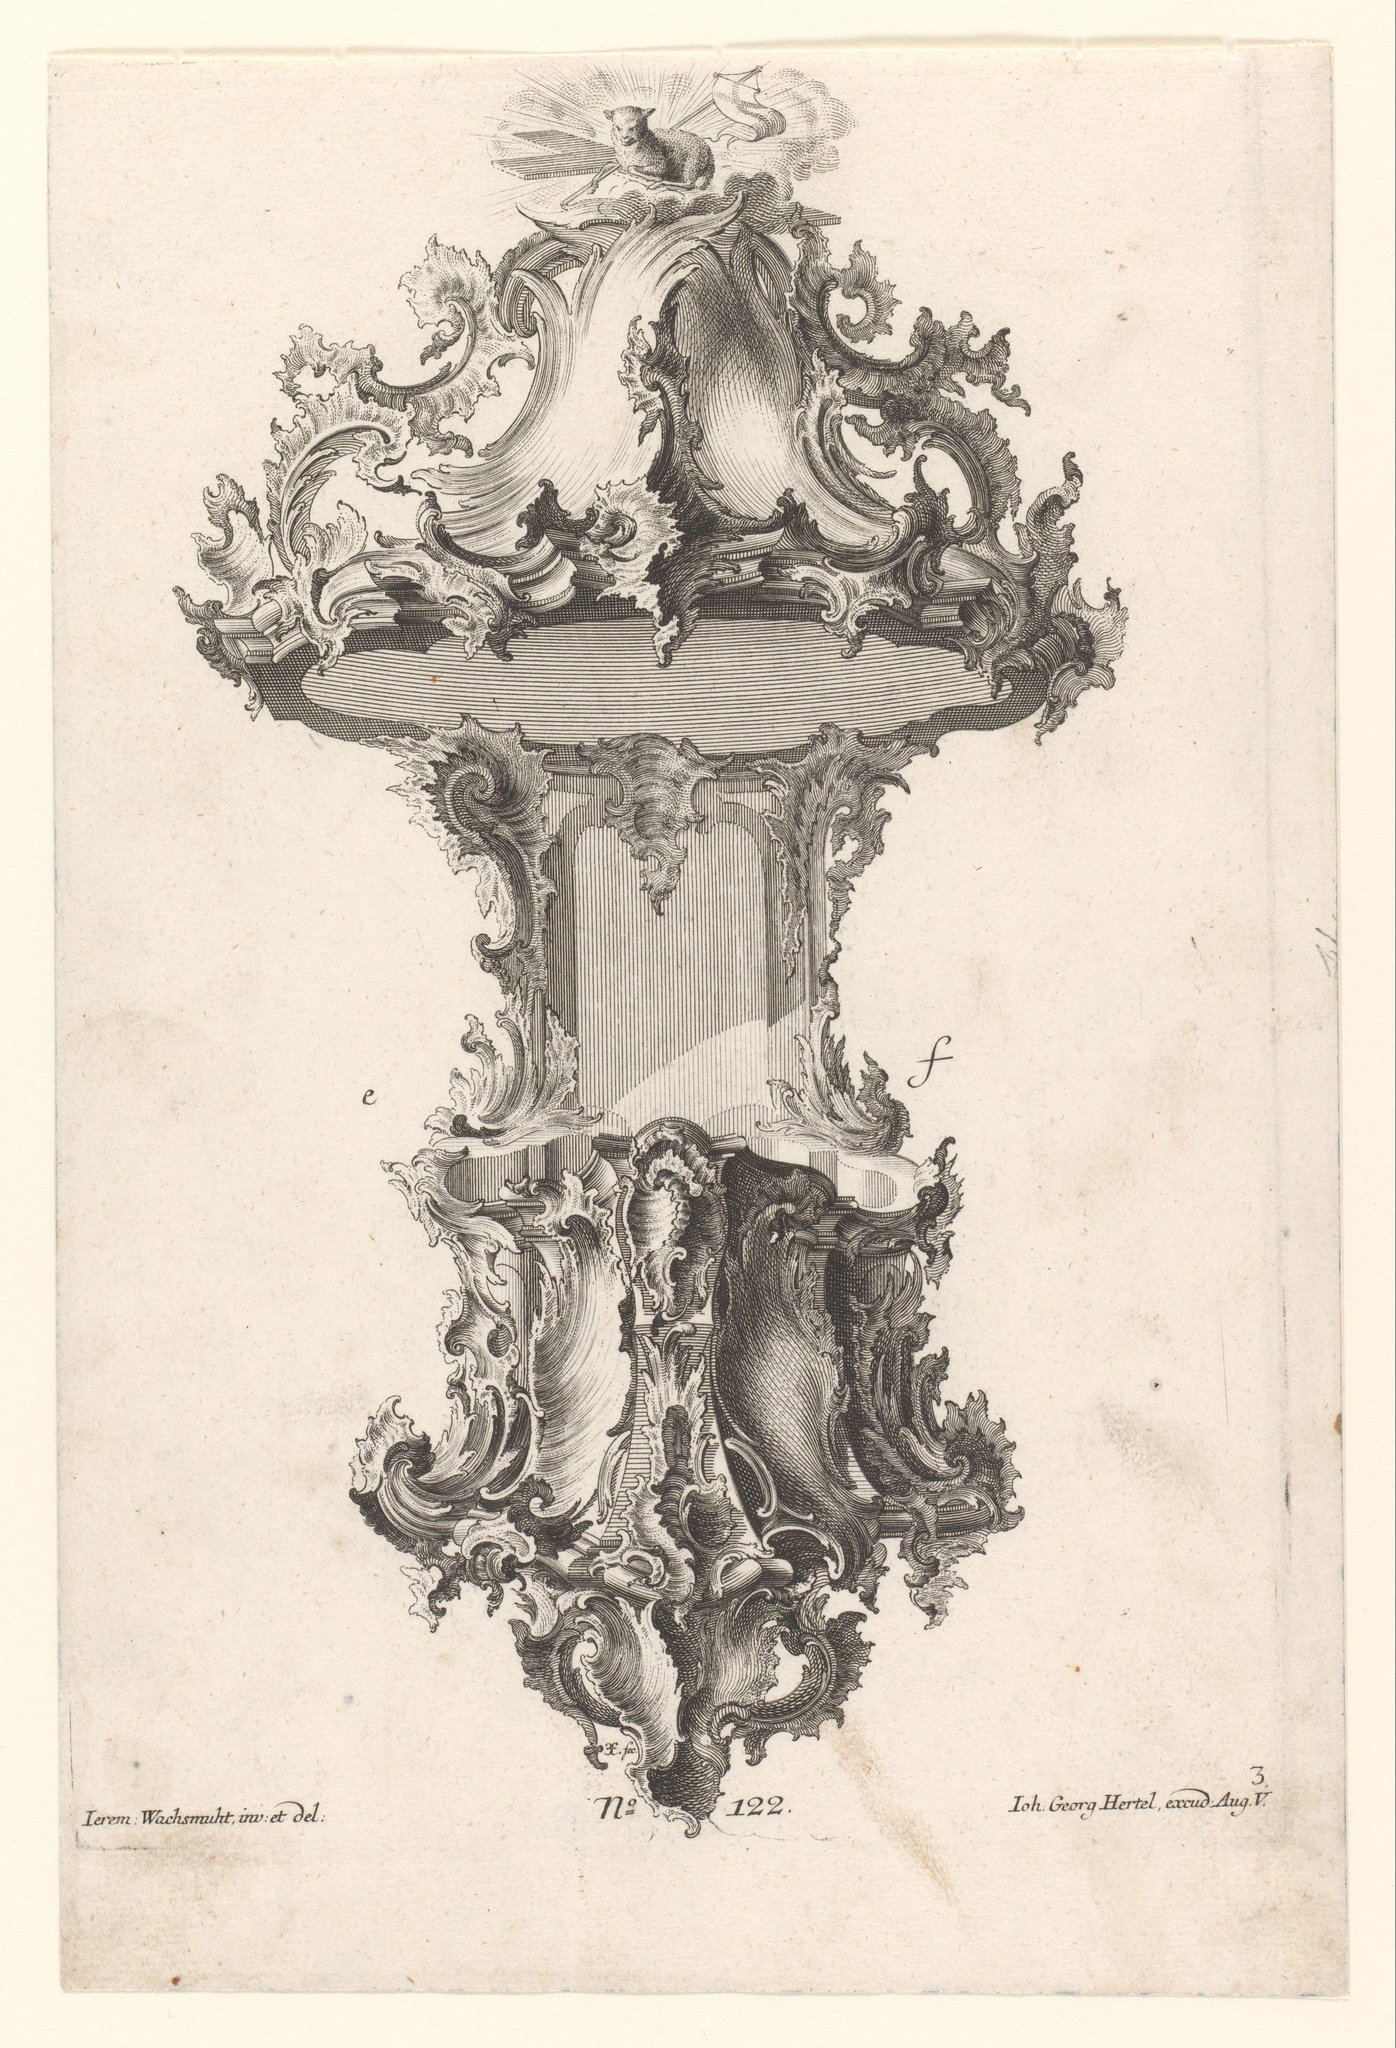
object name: ornament print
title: Preekstoel met Lam Gods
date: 1727-1771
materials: paper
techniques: engraving, etching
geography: augsburg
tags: rocaille ornament, lamb bearing cross or banner, 'agnus dei' ~ symbol of christ, pulpit, ambo, chancel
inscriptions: collector's mark: Lugt 2760, collector's mark: Lugt 2228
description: Een preekstoel met rocaille ornamenten, bekroond met het Lam Gods met een kruis en een banier. Uitgeversnummer 122.